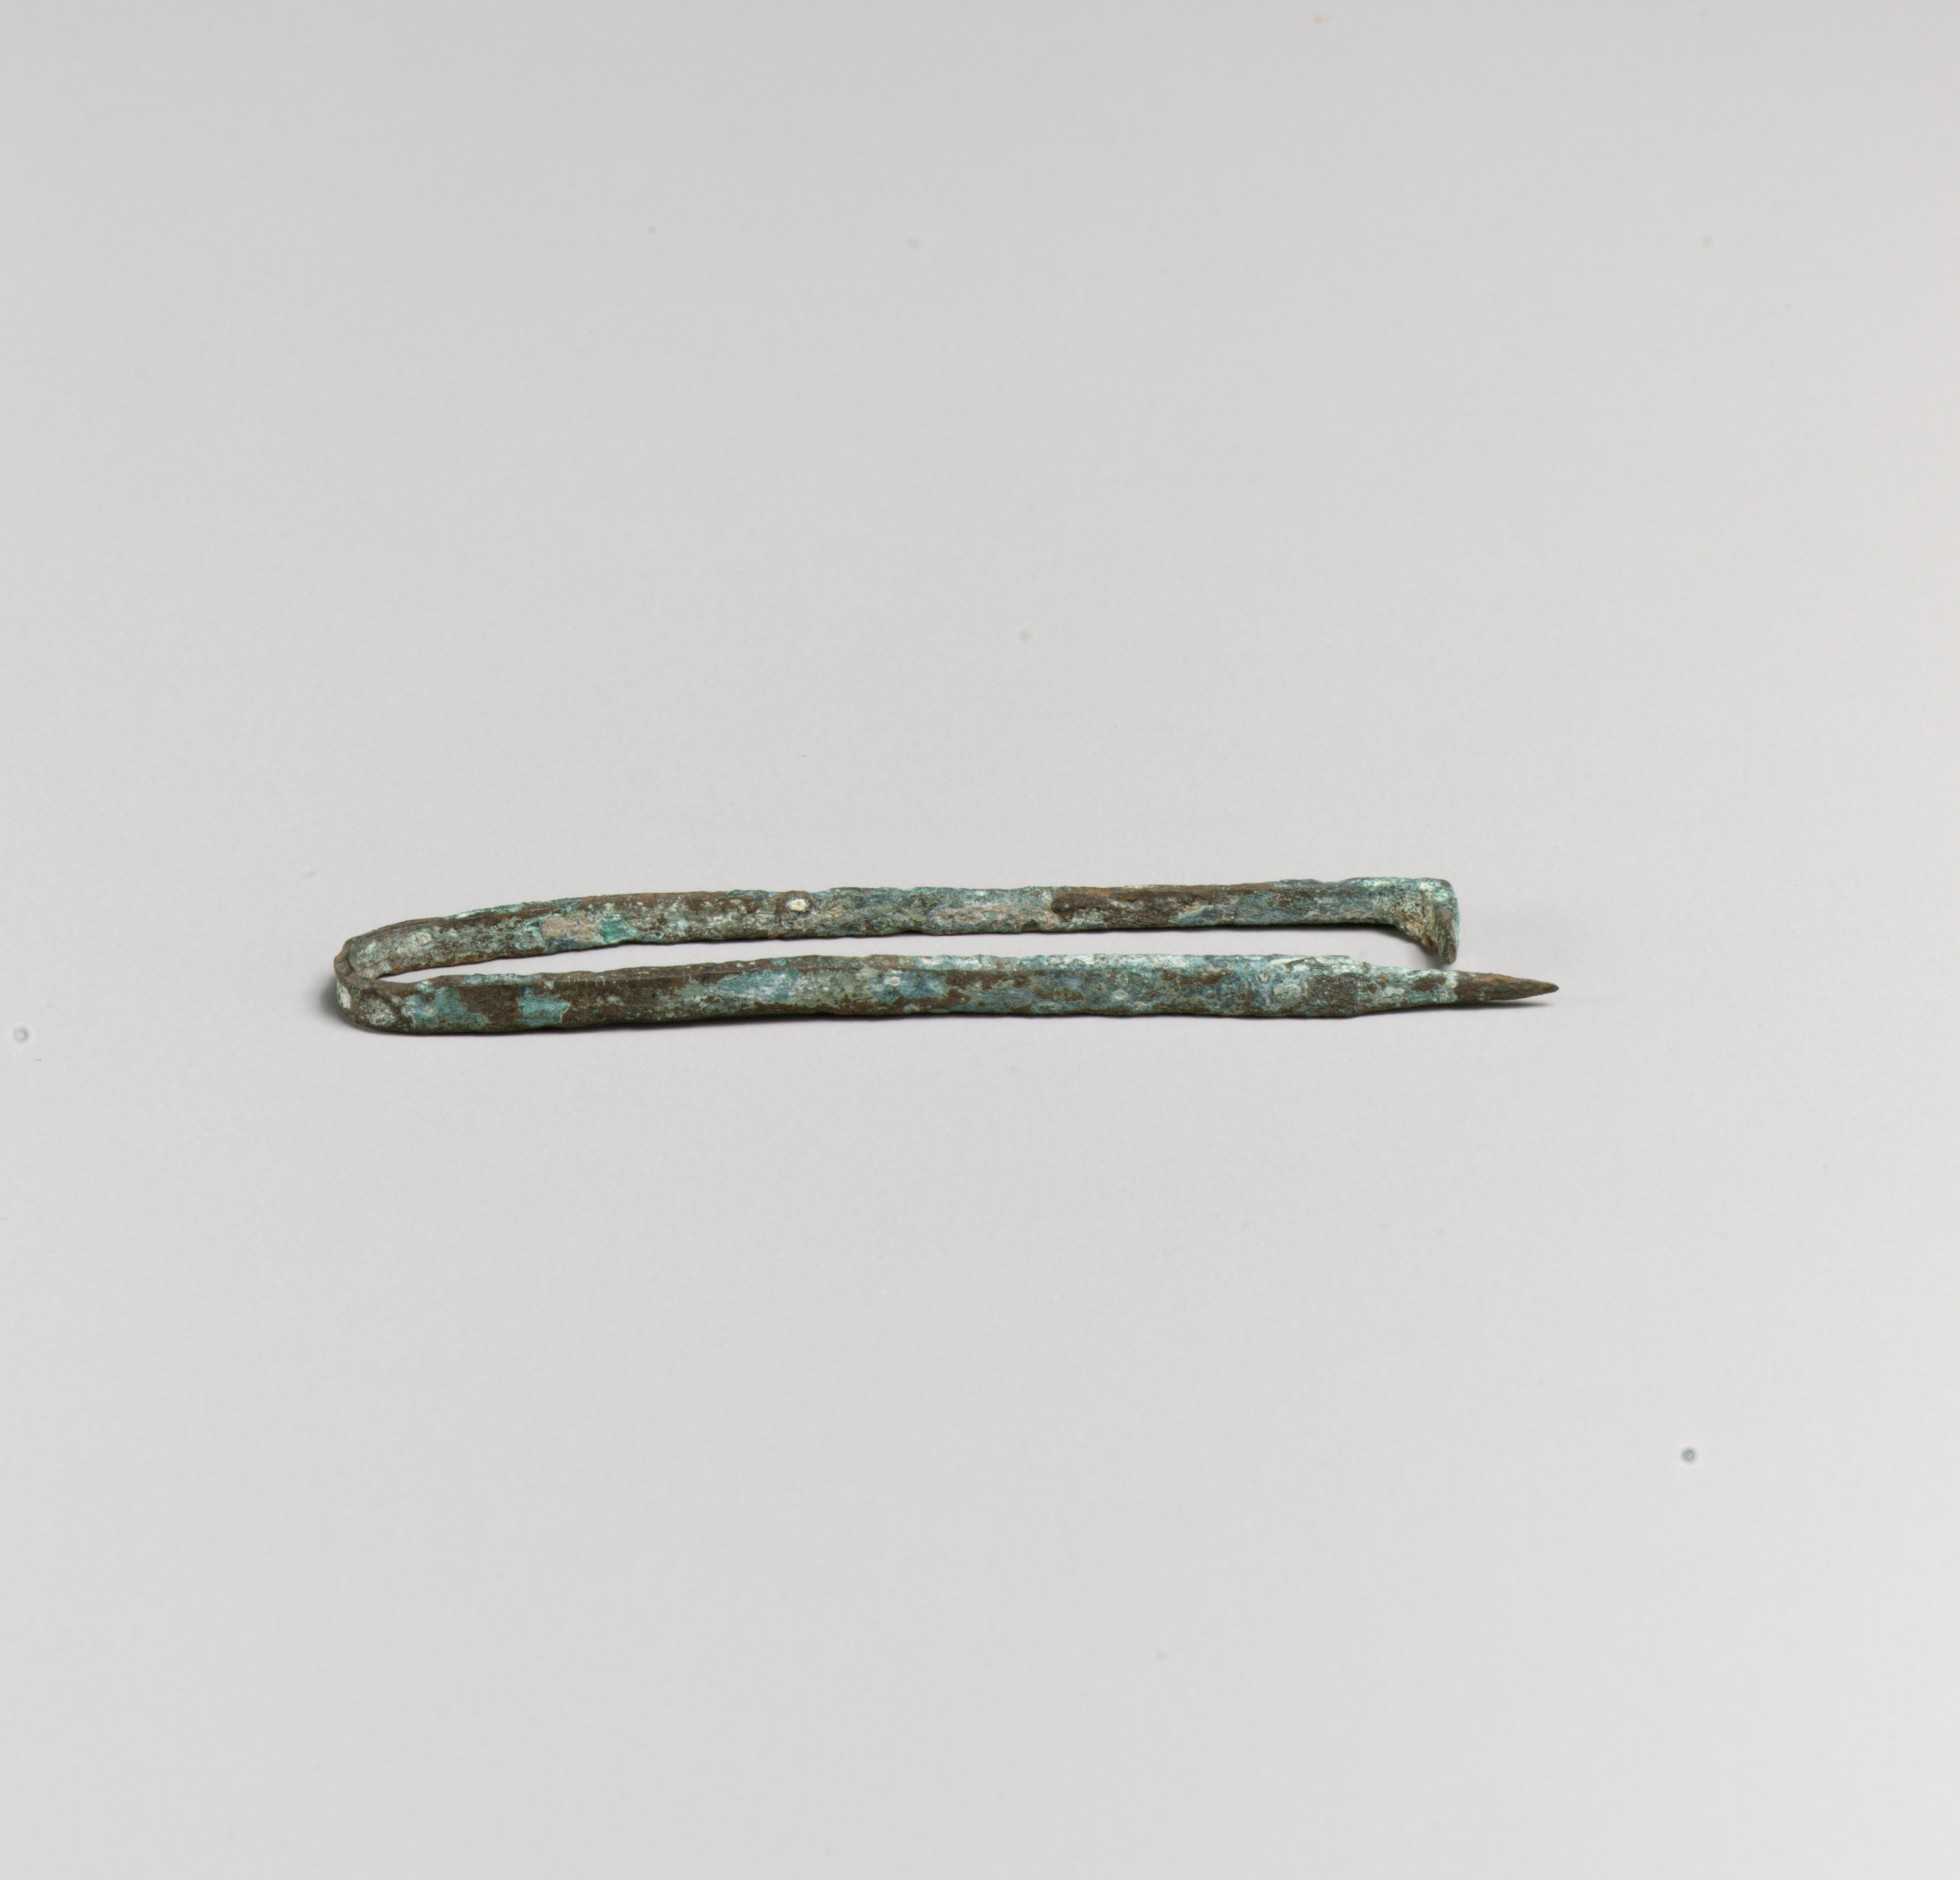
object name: fibula or pin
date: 7000 BCE-330 CE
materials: bronze